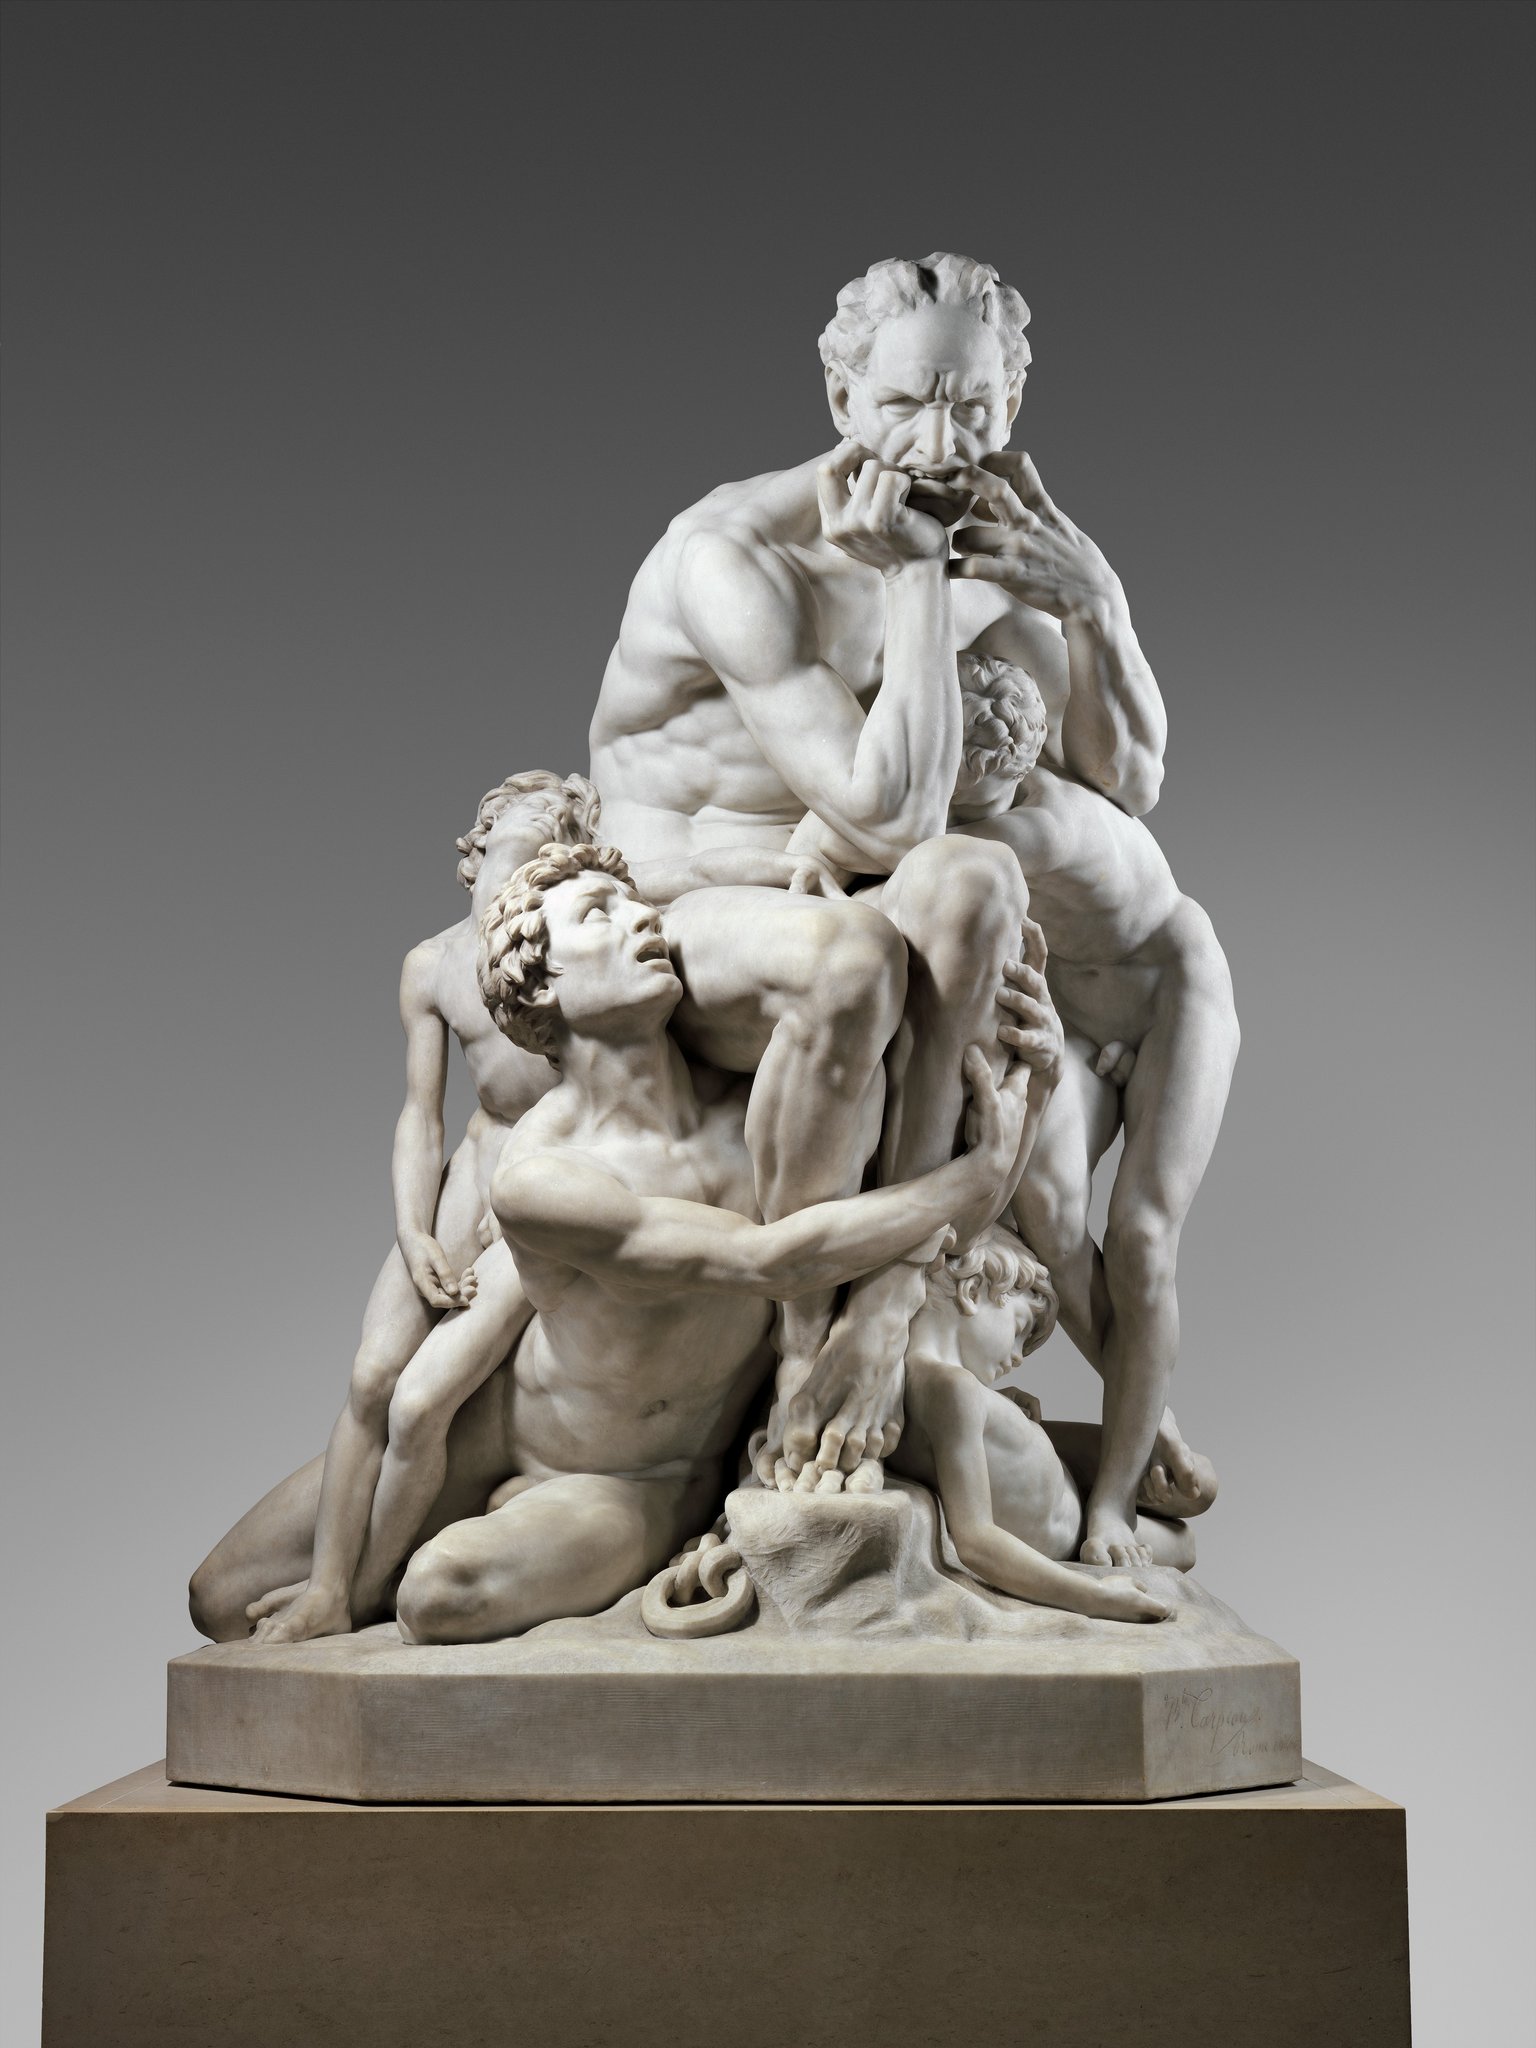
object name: group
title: Ugolino and His Sons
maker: jean-baptiste carpeaux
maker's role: artist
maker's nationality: french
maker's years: 1827-1875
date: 1865-1867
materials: marble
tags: suffering,boys,male nudes